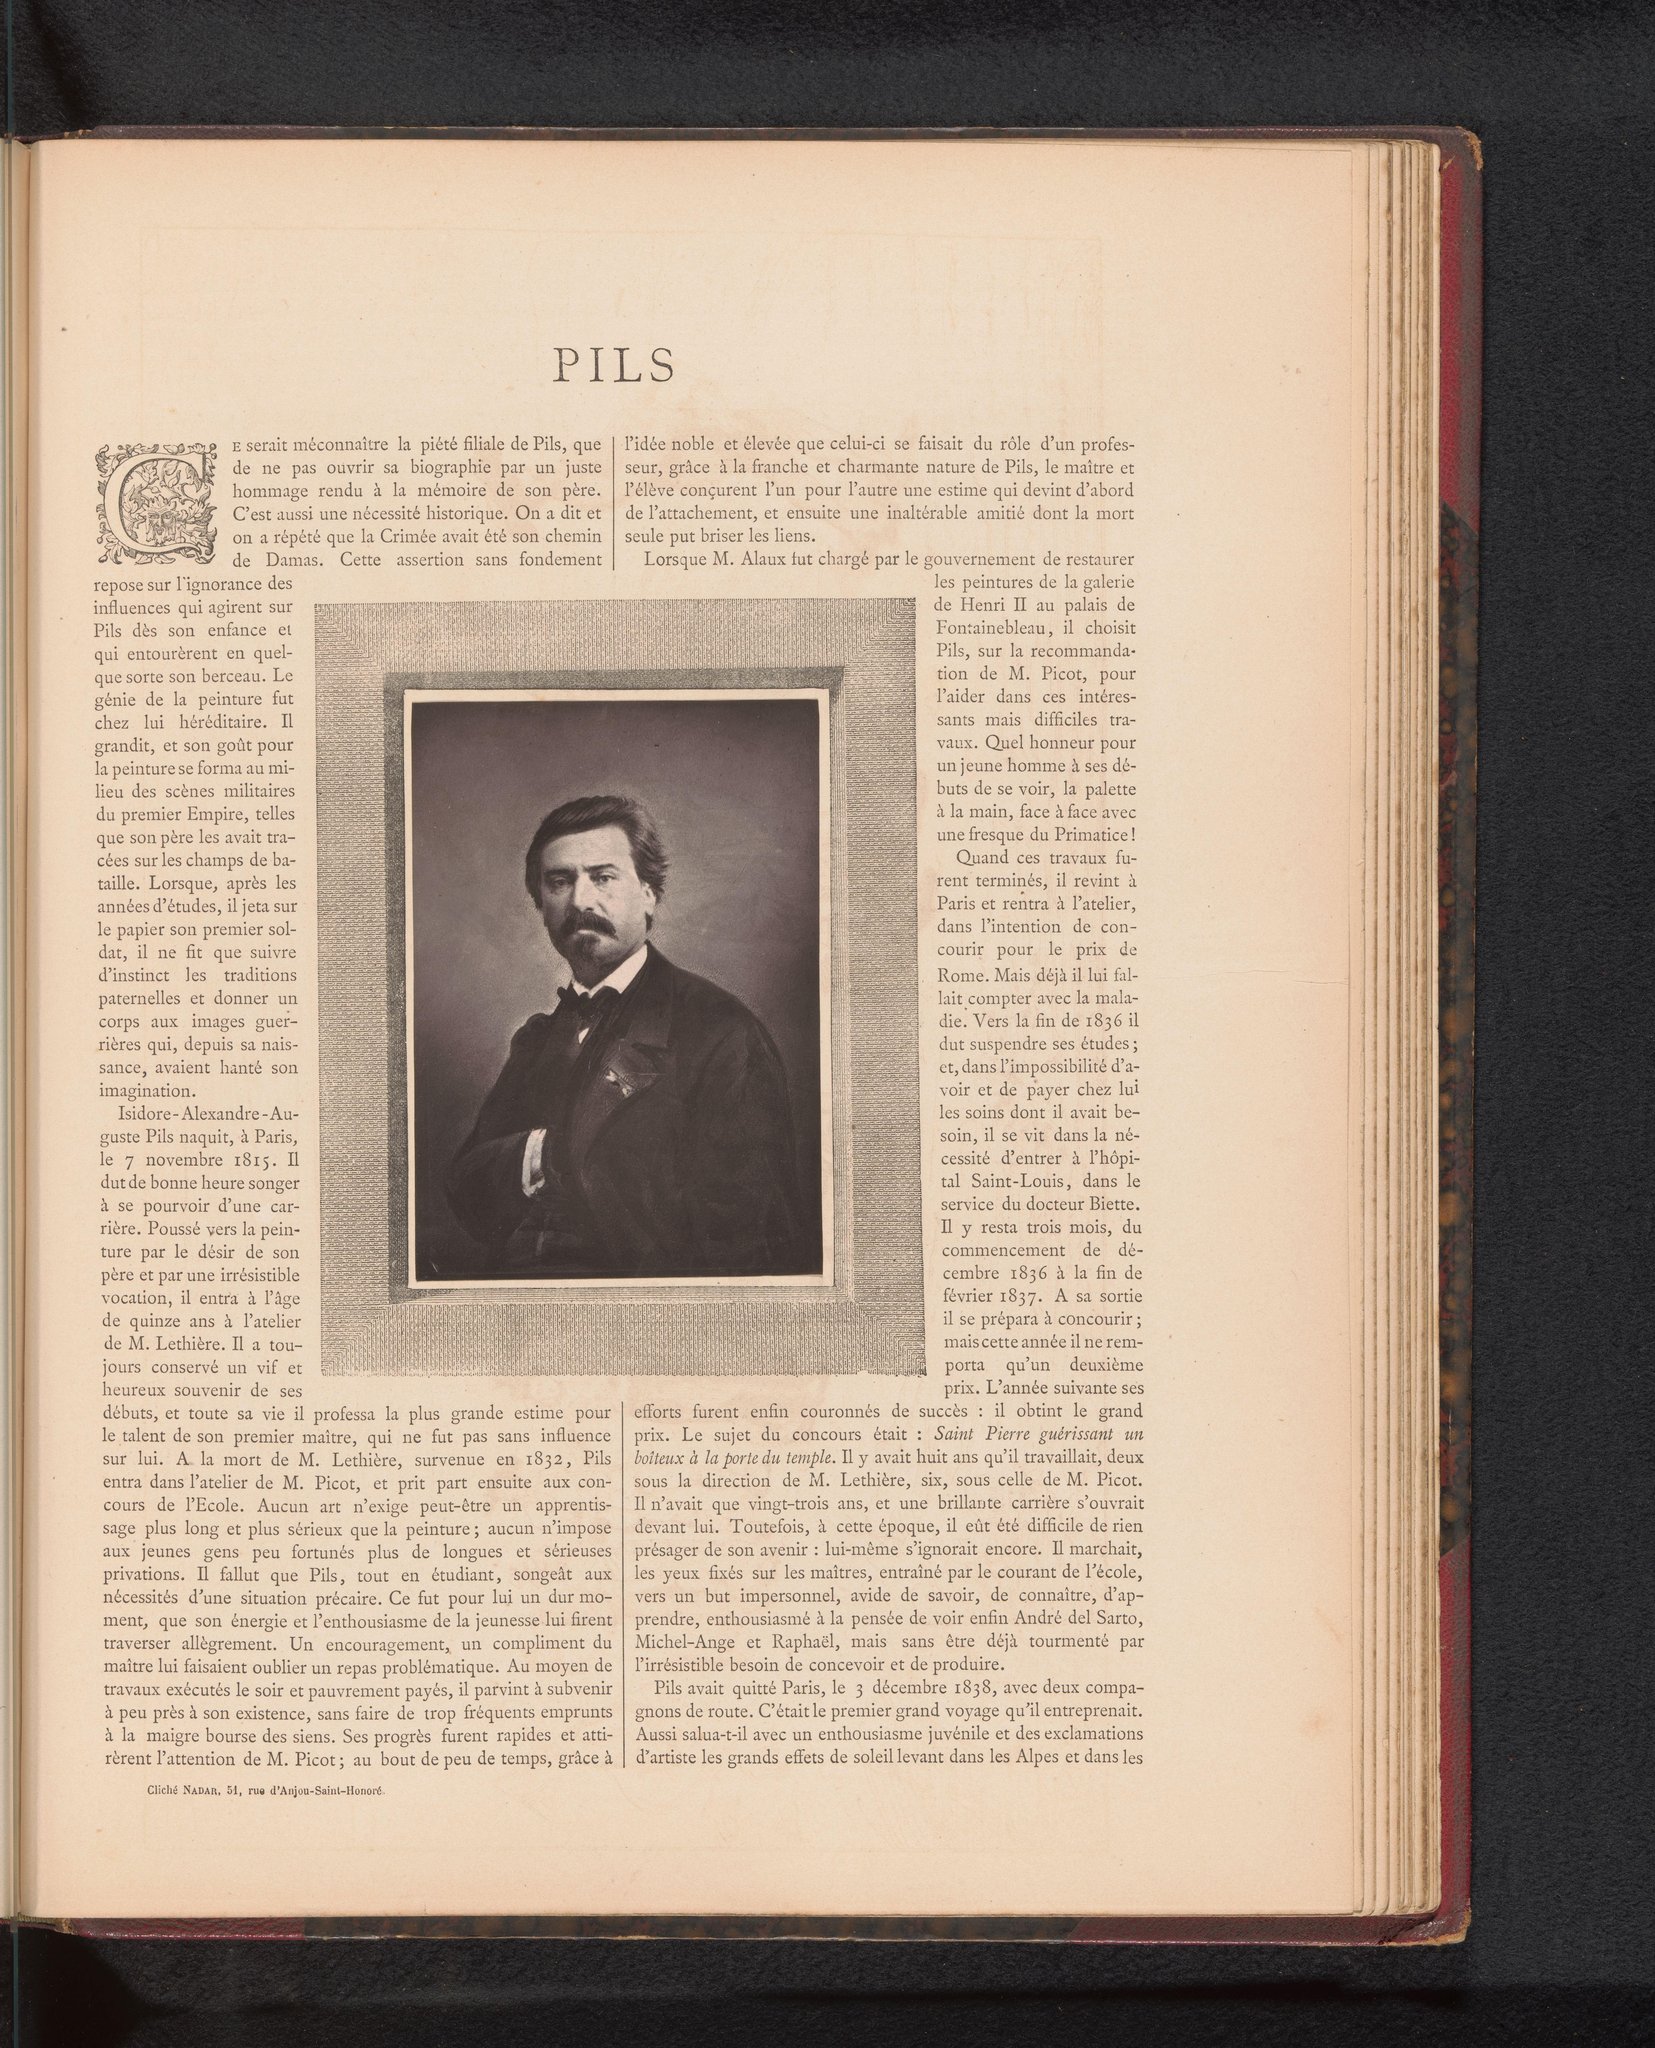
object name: photomechanical print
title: Pils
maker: félix nadar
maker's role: ballonvaarder, fotograaf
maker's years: 1820-1910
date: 1872-1877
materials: paper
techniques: woodburytype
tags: paris, painter, isidore pils, adult man, historical persons